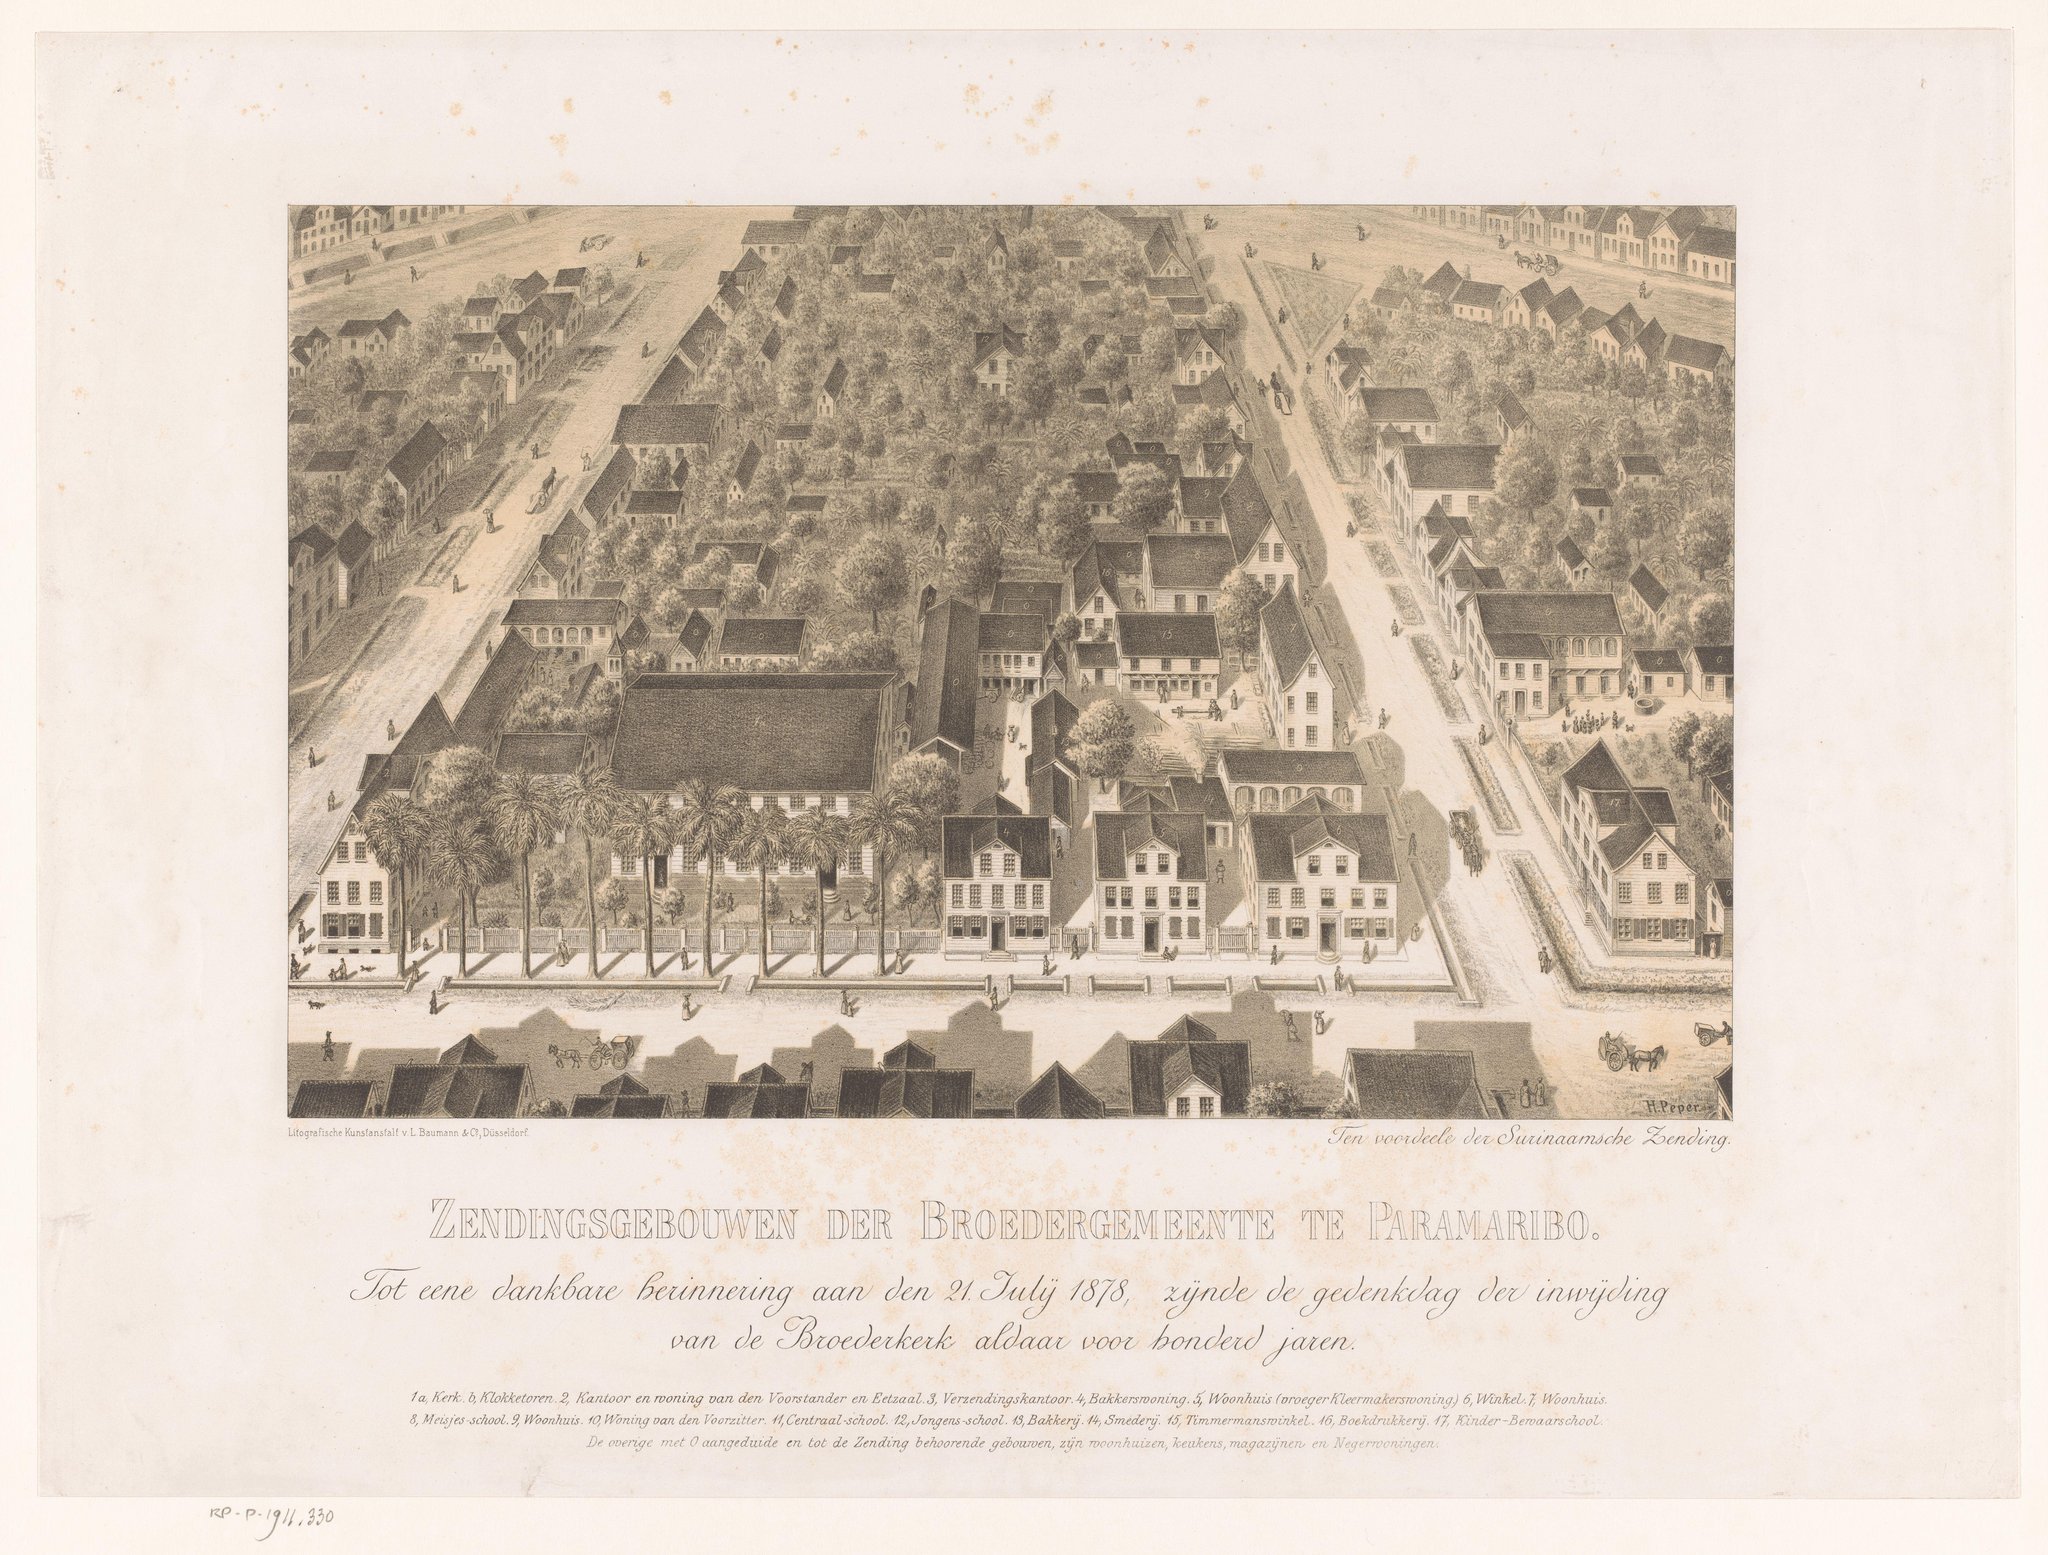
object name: print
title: Gezicht op gebouwen van de Evangelische Broedergemeente in Paramaribo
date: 1878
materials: paper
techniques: lithograph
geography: dusseldorf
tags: prospect of city, town panorama, silhouette of city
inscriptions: collector's mark: Lugt 2228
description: Prent uitgegeven ten behoeve van de Surinaamse Zending, bij de 100-jarige gedenkdag van de inwijding van de Broederkerk.